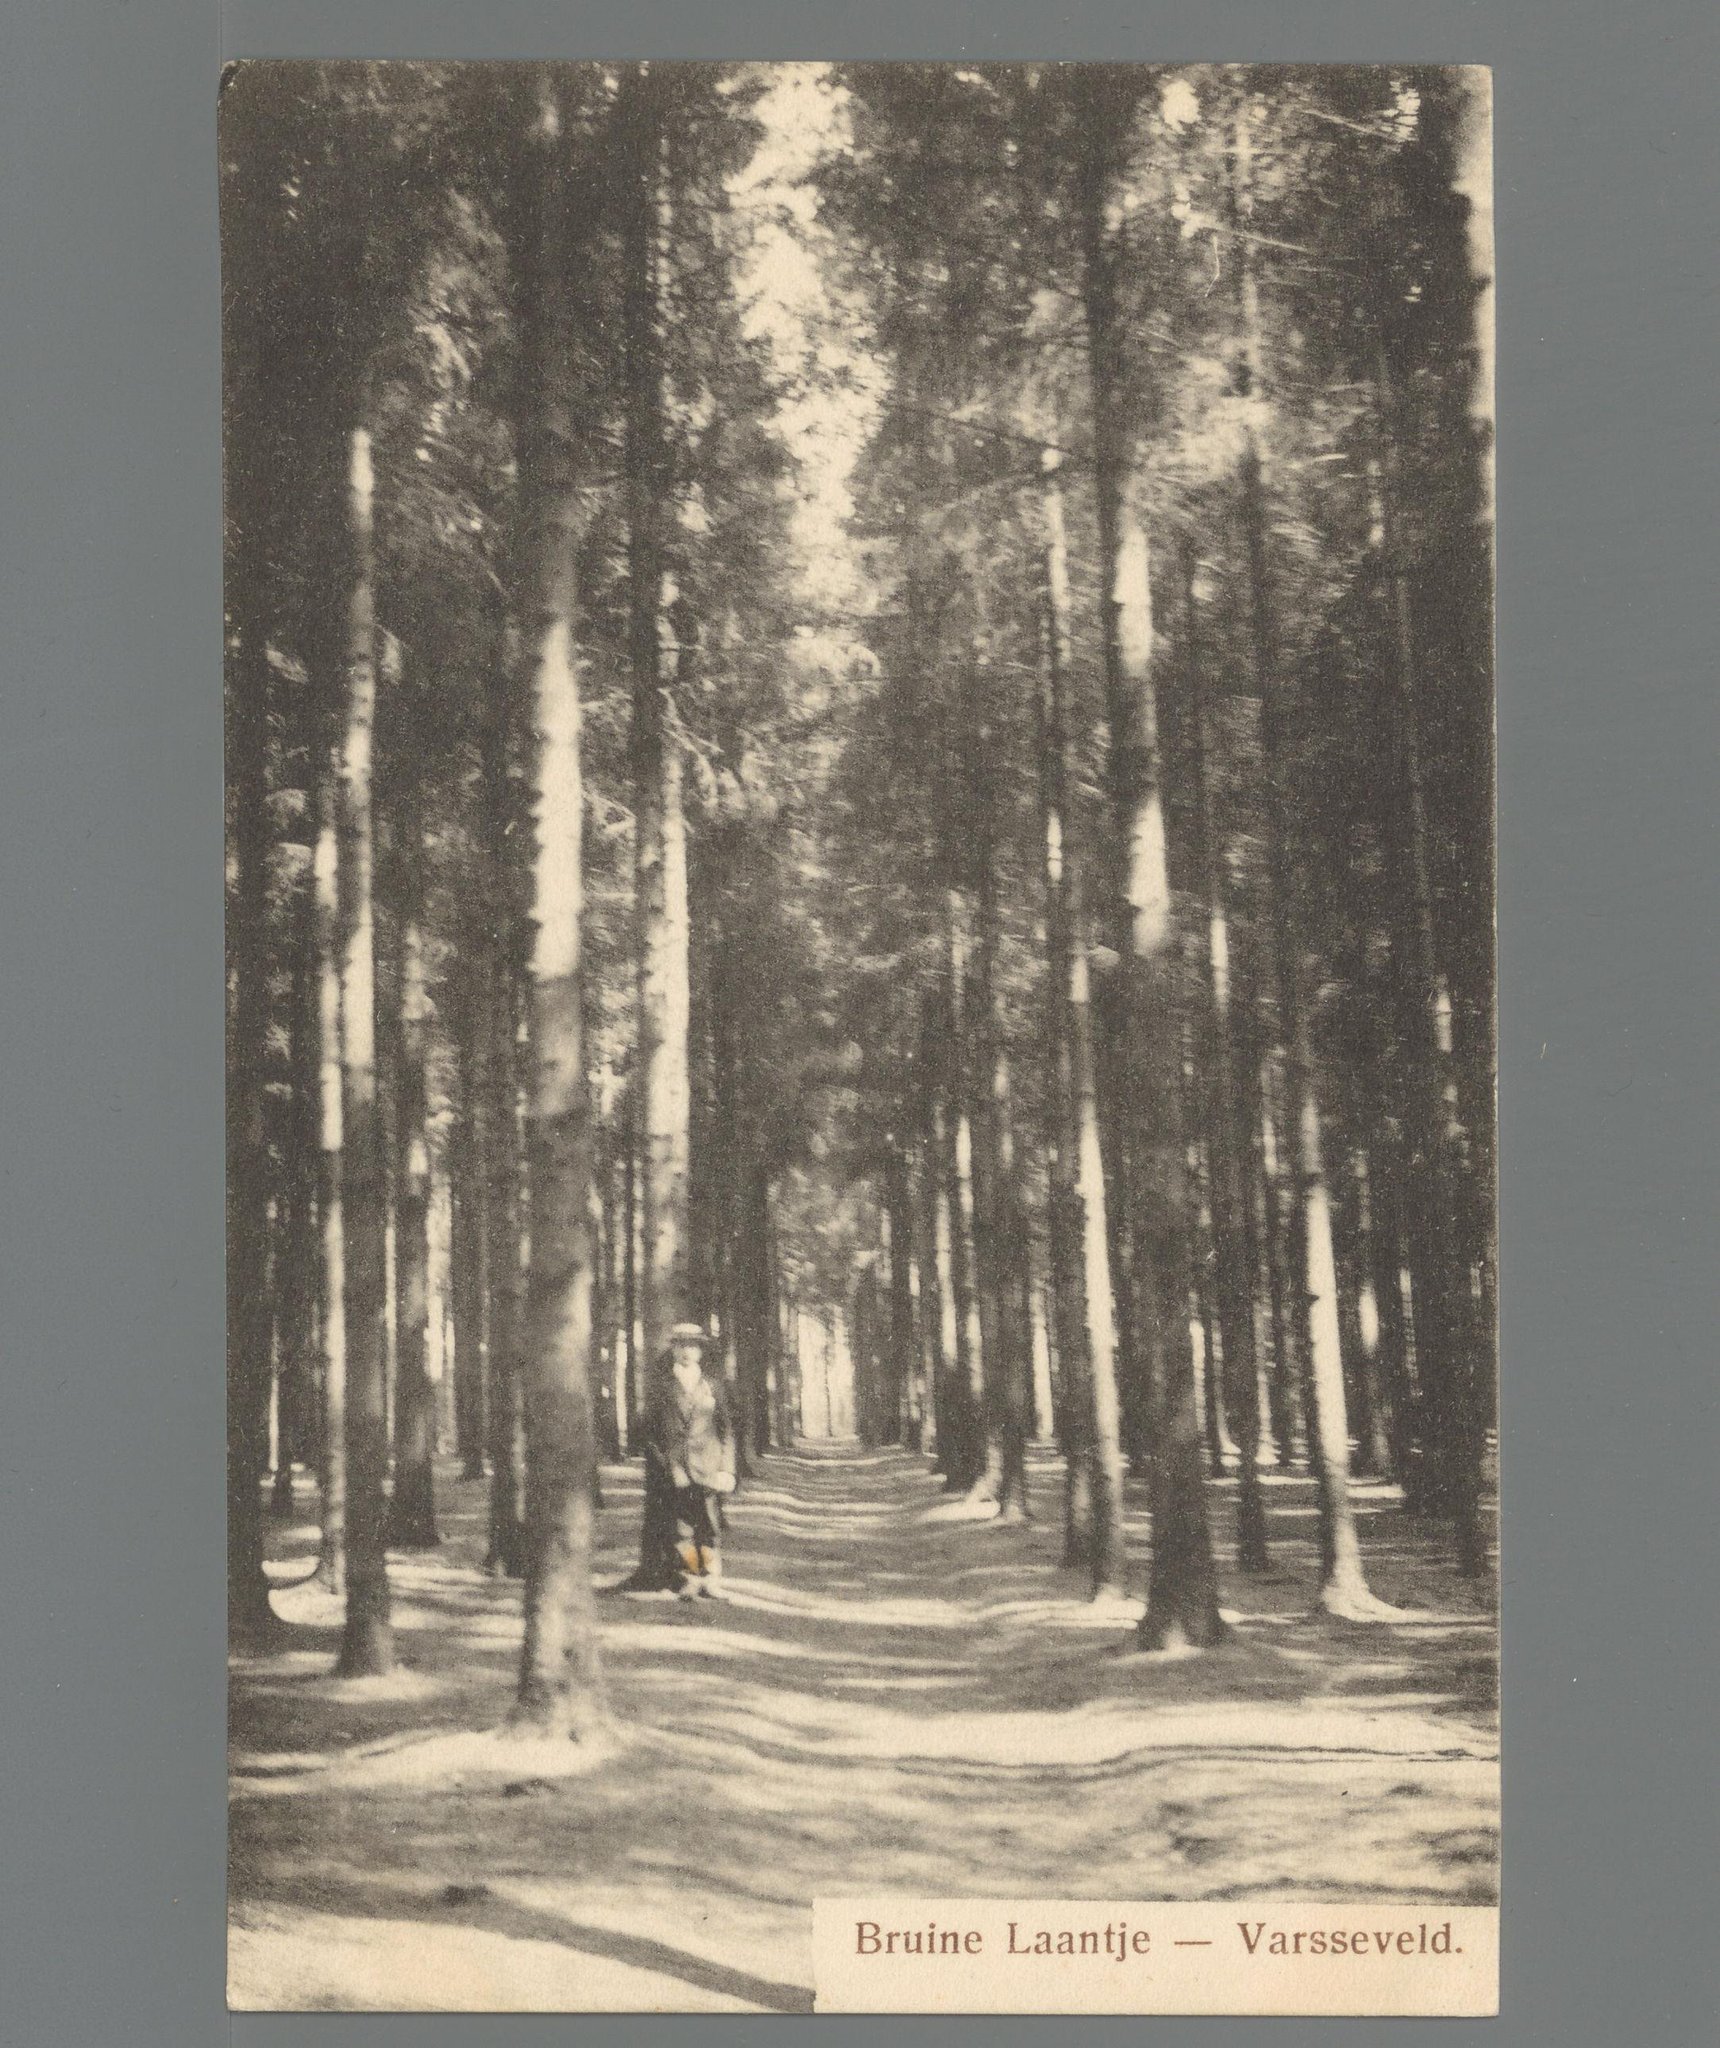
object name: ansichtkaart, prentbriefkaart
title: Bruine Laantje - Varsseveld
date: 1905-1930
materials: cardboard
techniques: photograph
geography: varsseveld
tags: forest path or lane